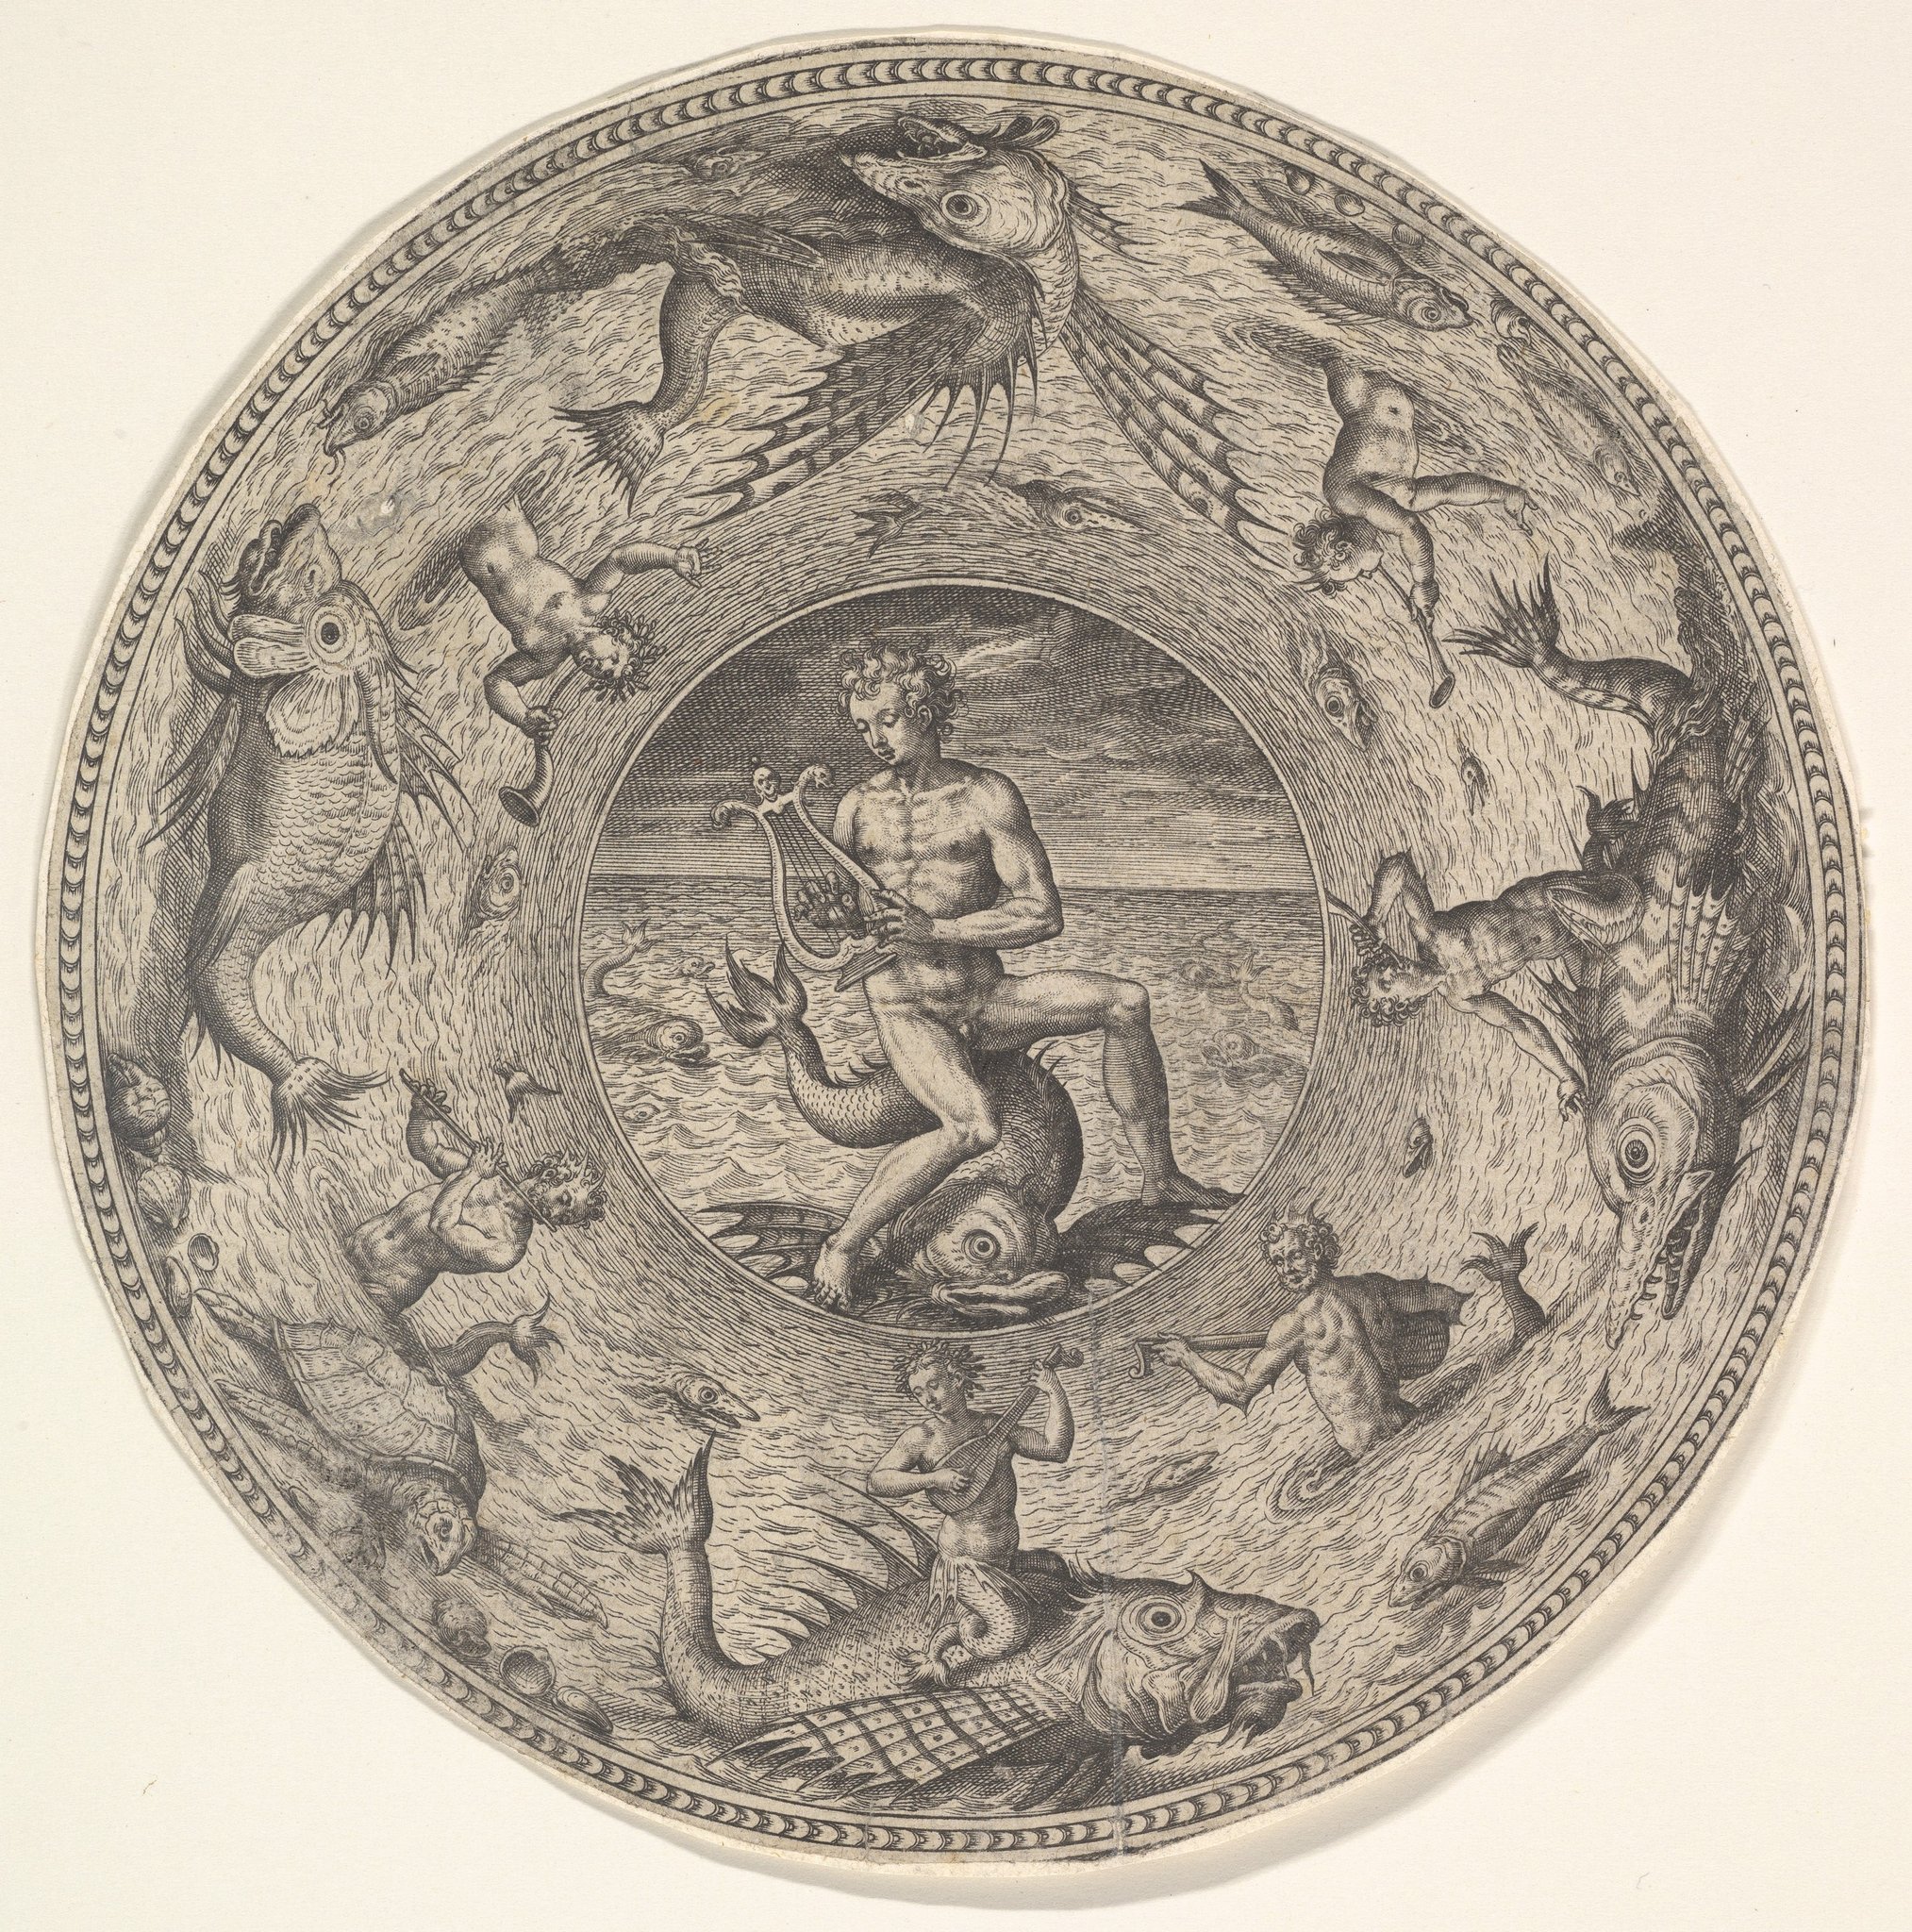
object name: print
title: Arion on a Dolphin surrounded by a Border decorated with Sea Creatures, from a set of circular designs with sea gods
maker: adriaen collaert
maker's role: artist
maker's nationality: netherlandish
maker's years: 1560-1618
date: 1580-1600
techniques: engraving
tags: male nudes,dolphins,fish,lyres